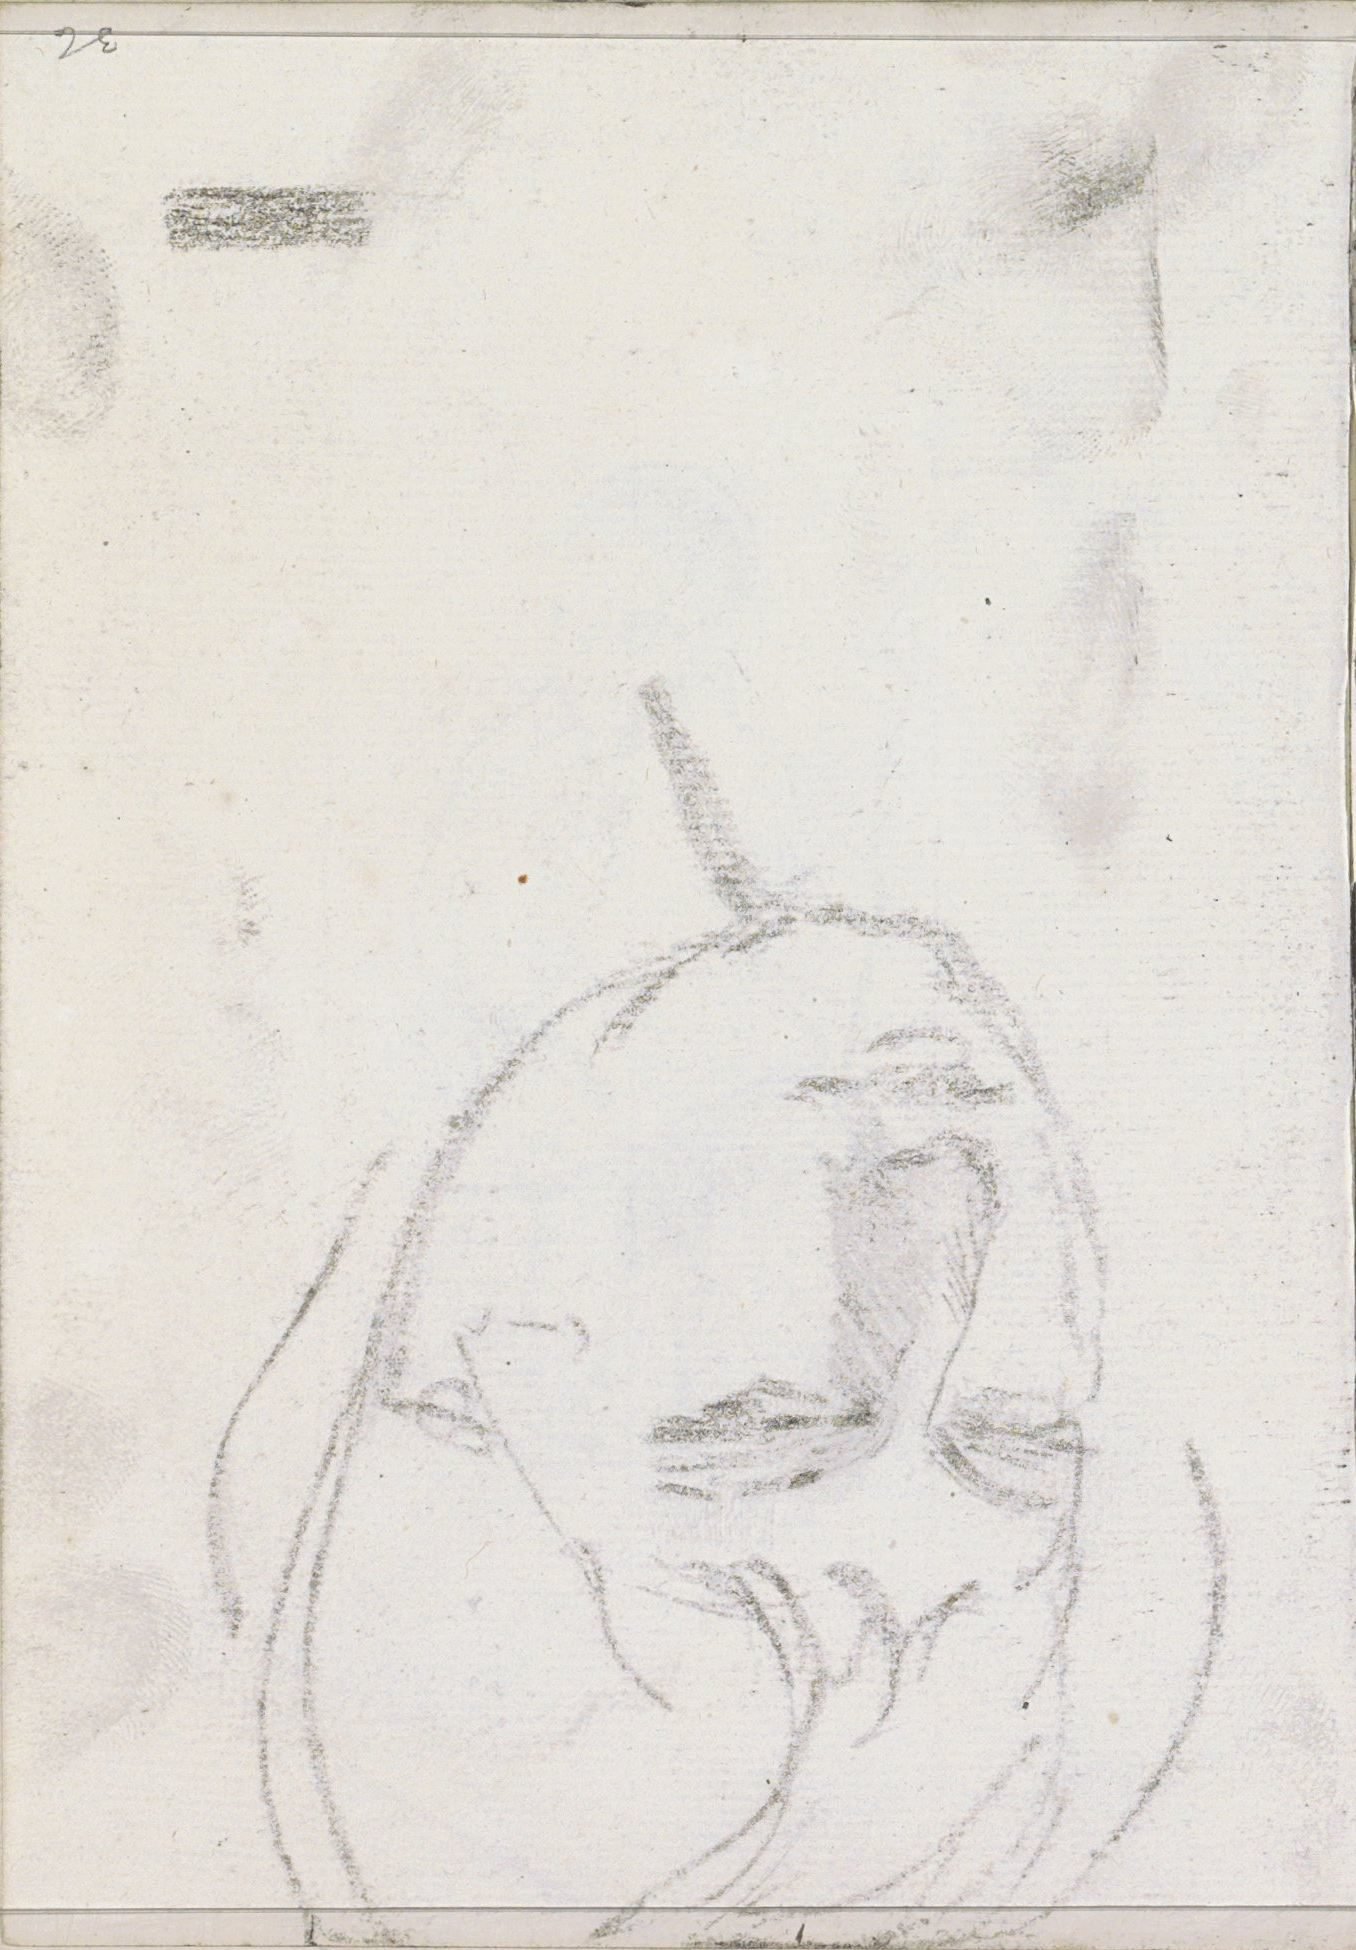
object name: sketchbook leaf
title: Vrouwenhoofd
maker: isaac israels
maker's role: draughtsman, painter, print maker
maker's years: 1865-1934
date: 1886-1934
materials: chalk, paper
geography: amsterdam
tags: head (human) - aa - female human figure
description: Blad 7 verso uit schetsboek LV met 21 bladen.